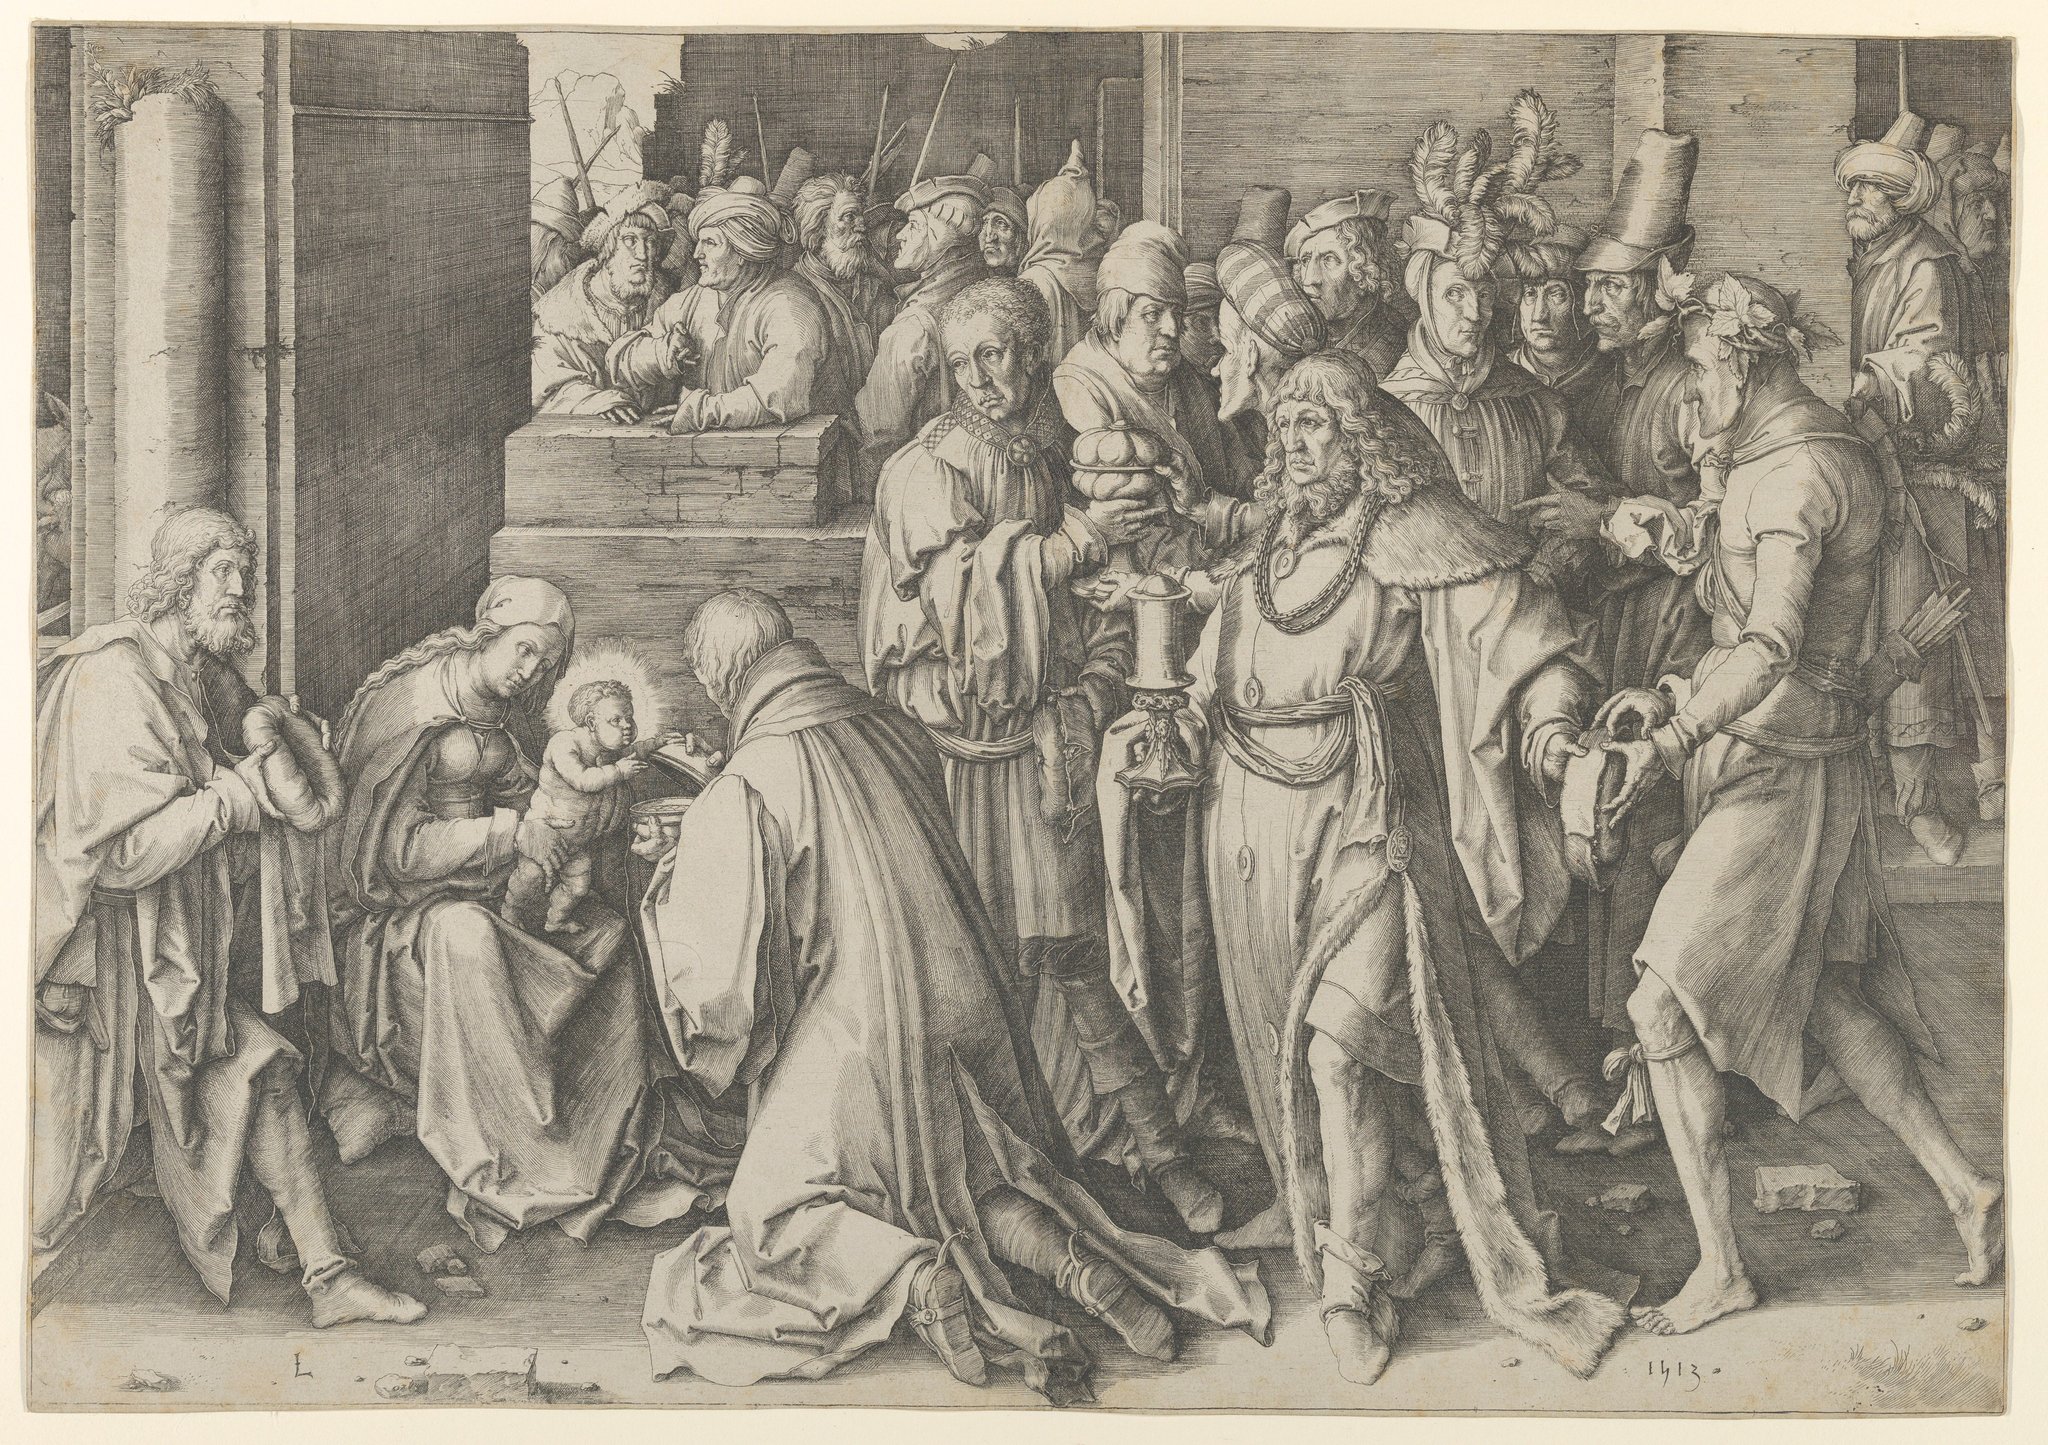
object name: print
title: Adoration of the Magi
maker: lucas van leyden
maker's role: artist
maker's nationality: netherlandish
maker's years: 1494-1533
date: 1513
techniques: engraving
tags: adoration of the magi